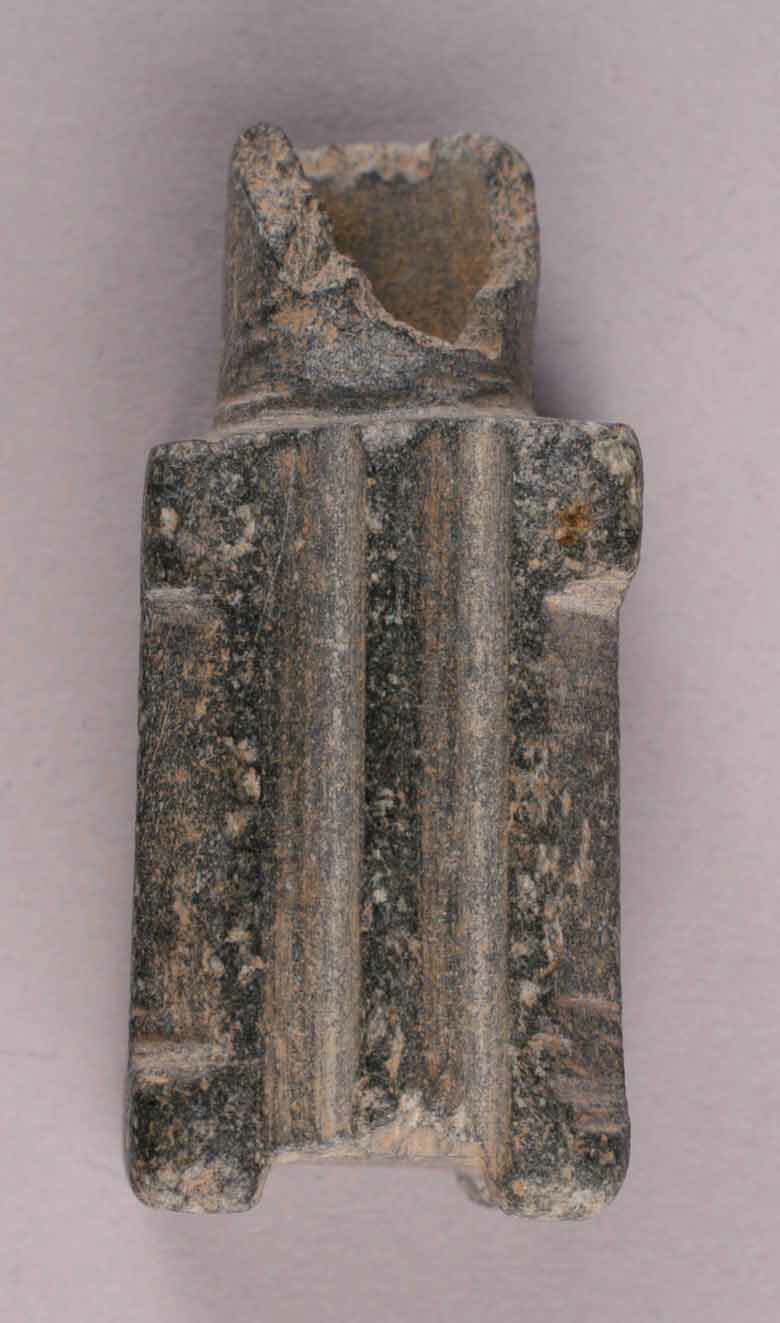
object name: bottle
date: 801-1000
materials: stone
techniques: carving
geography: iran